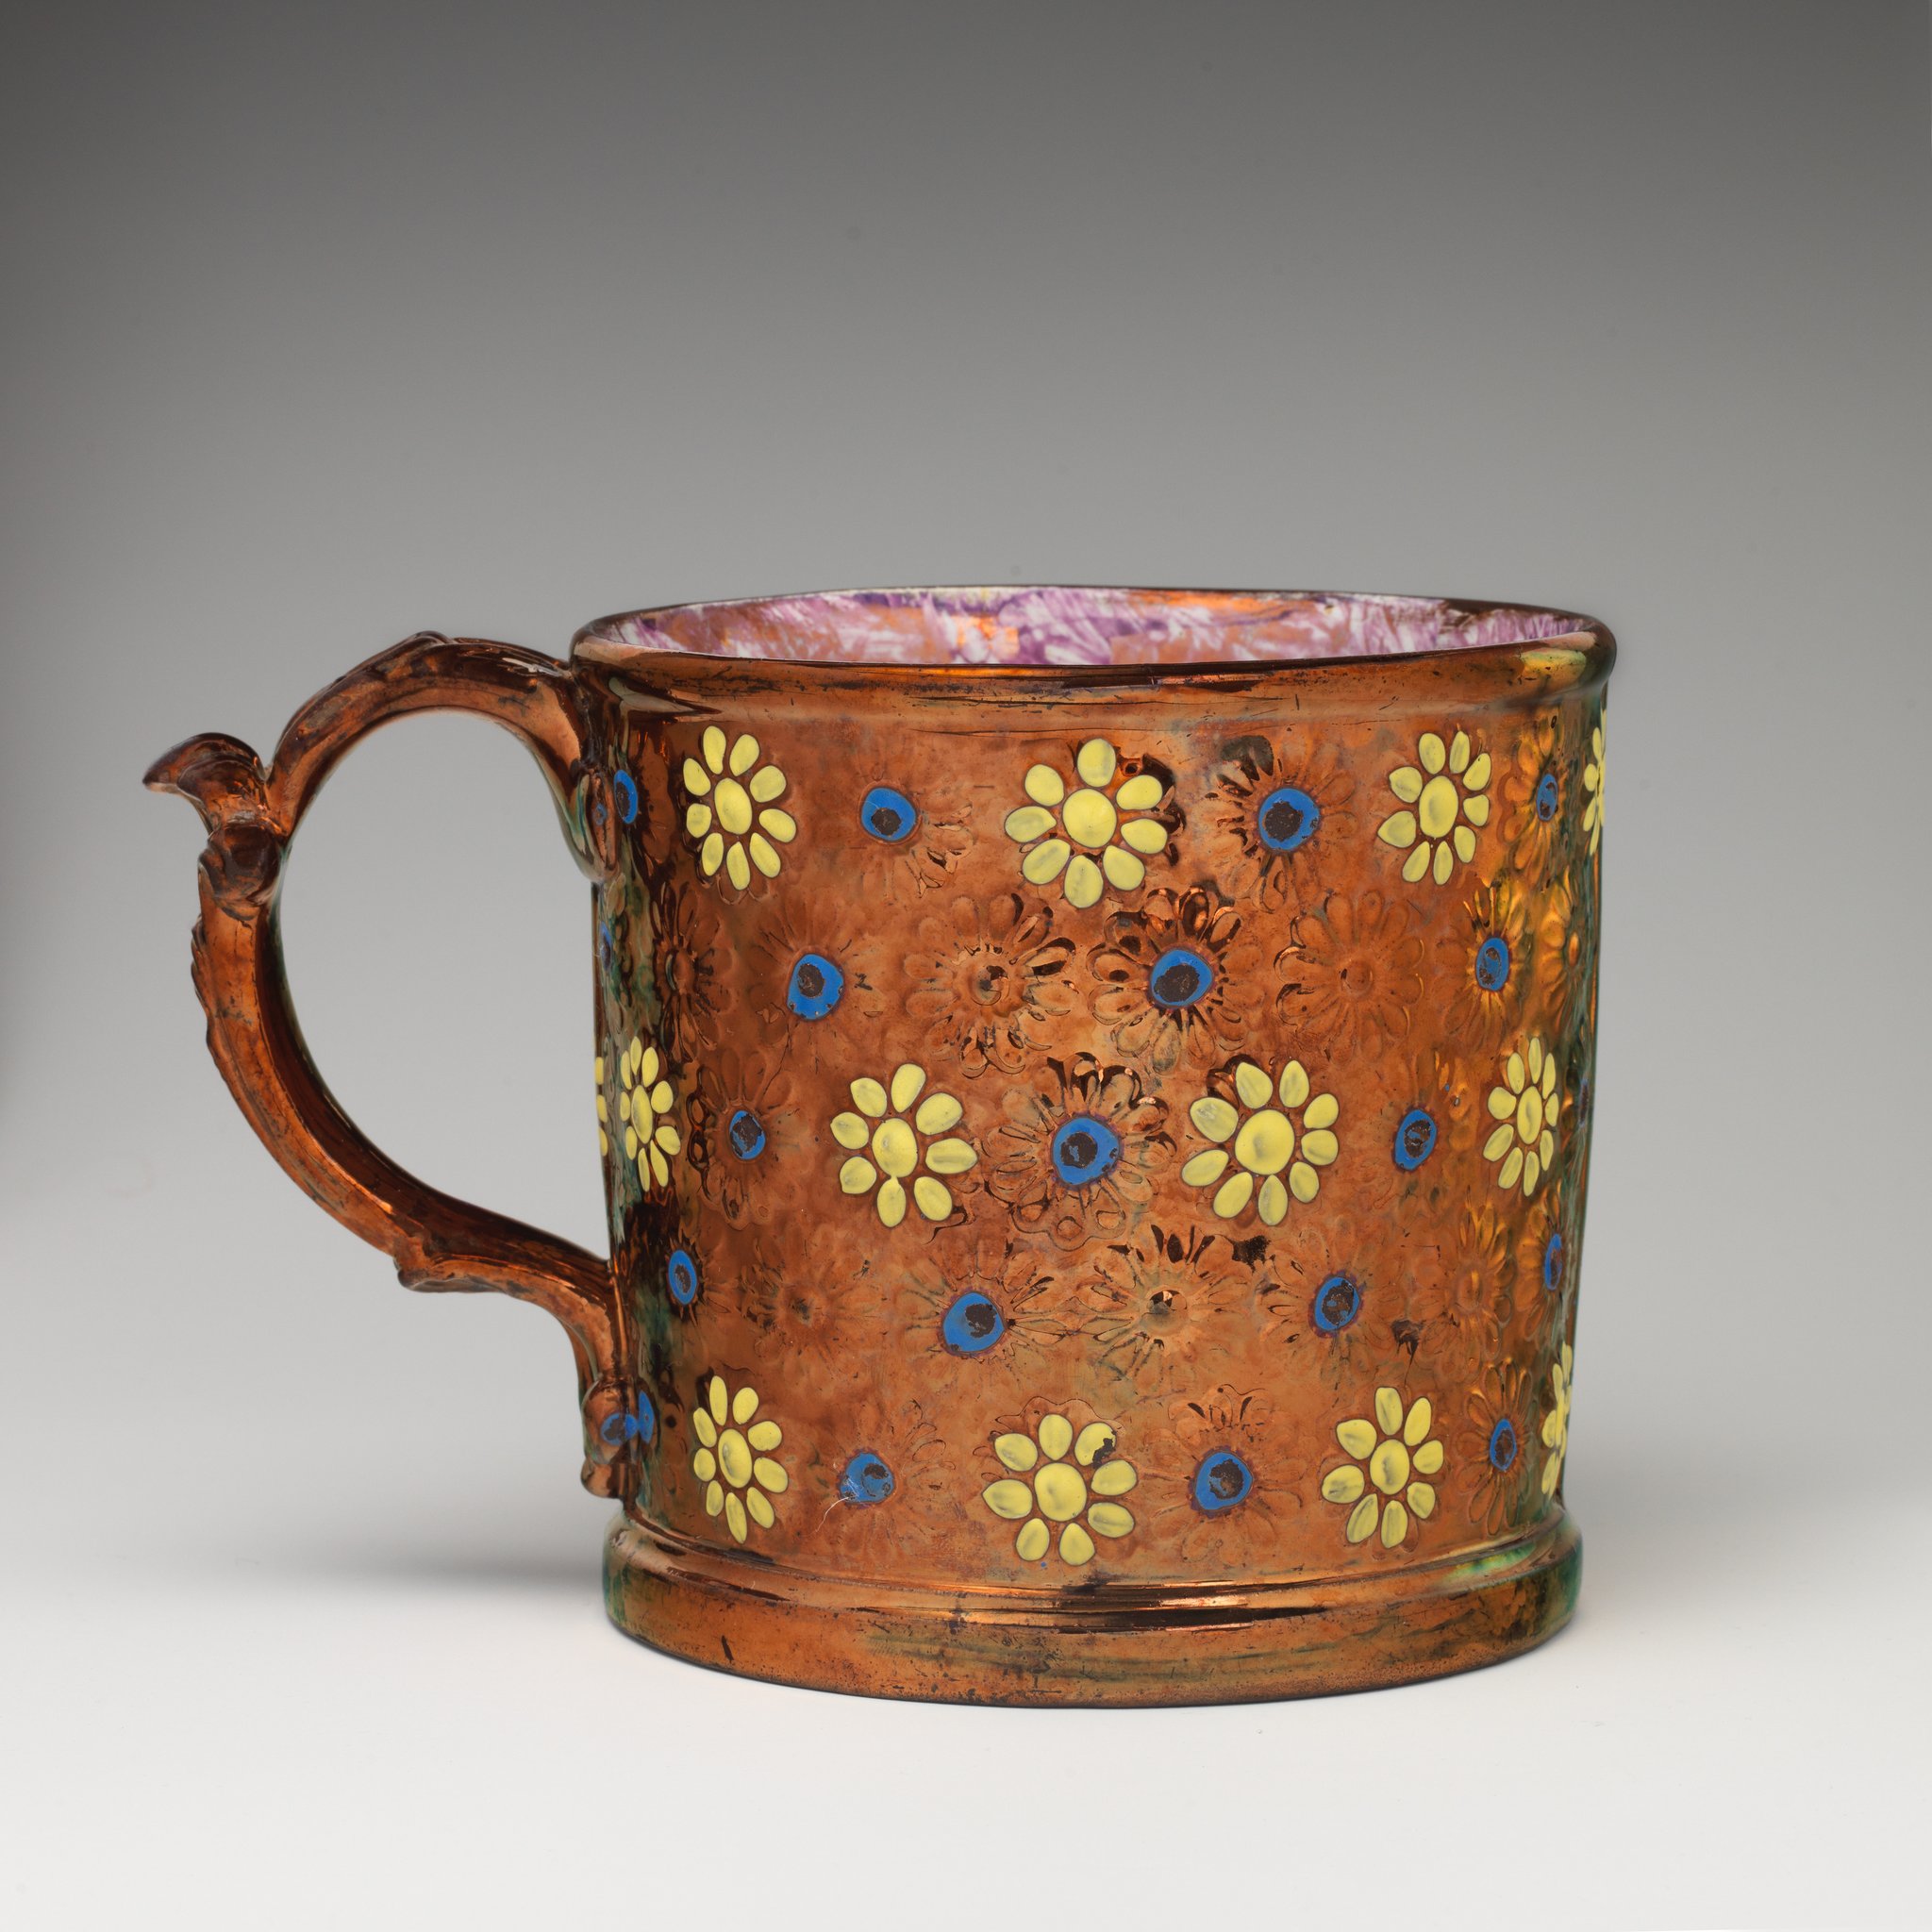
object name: mug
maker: durham co.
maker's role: factory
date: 1801-1833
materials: pottery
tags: flowers